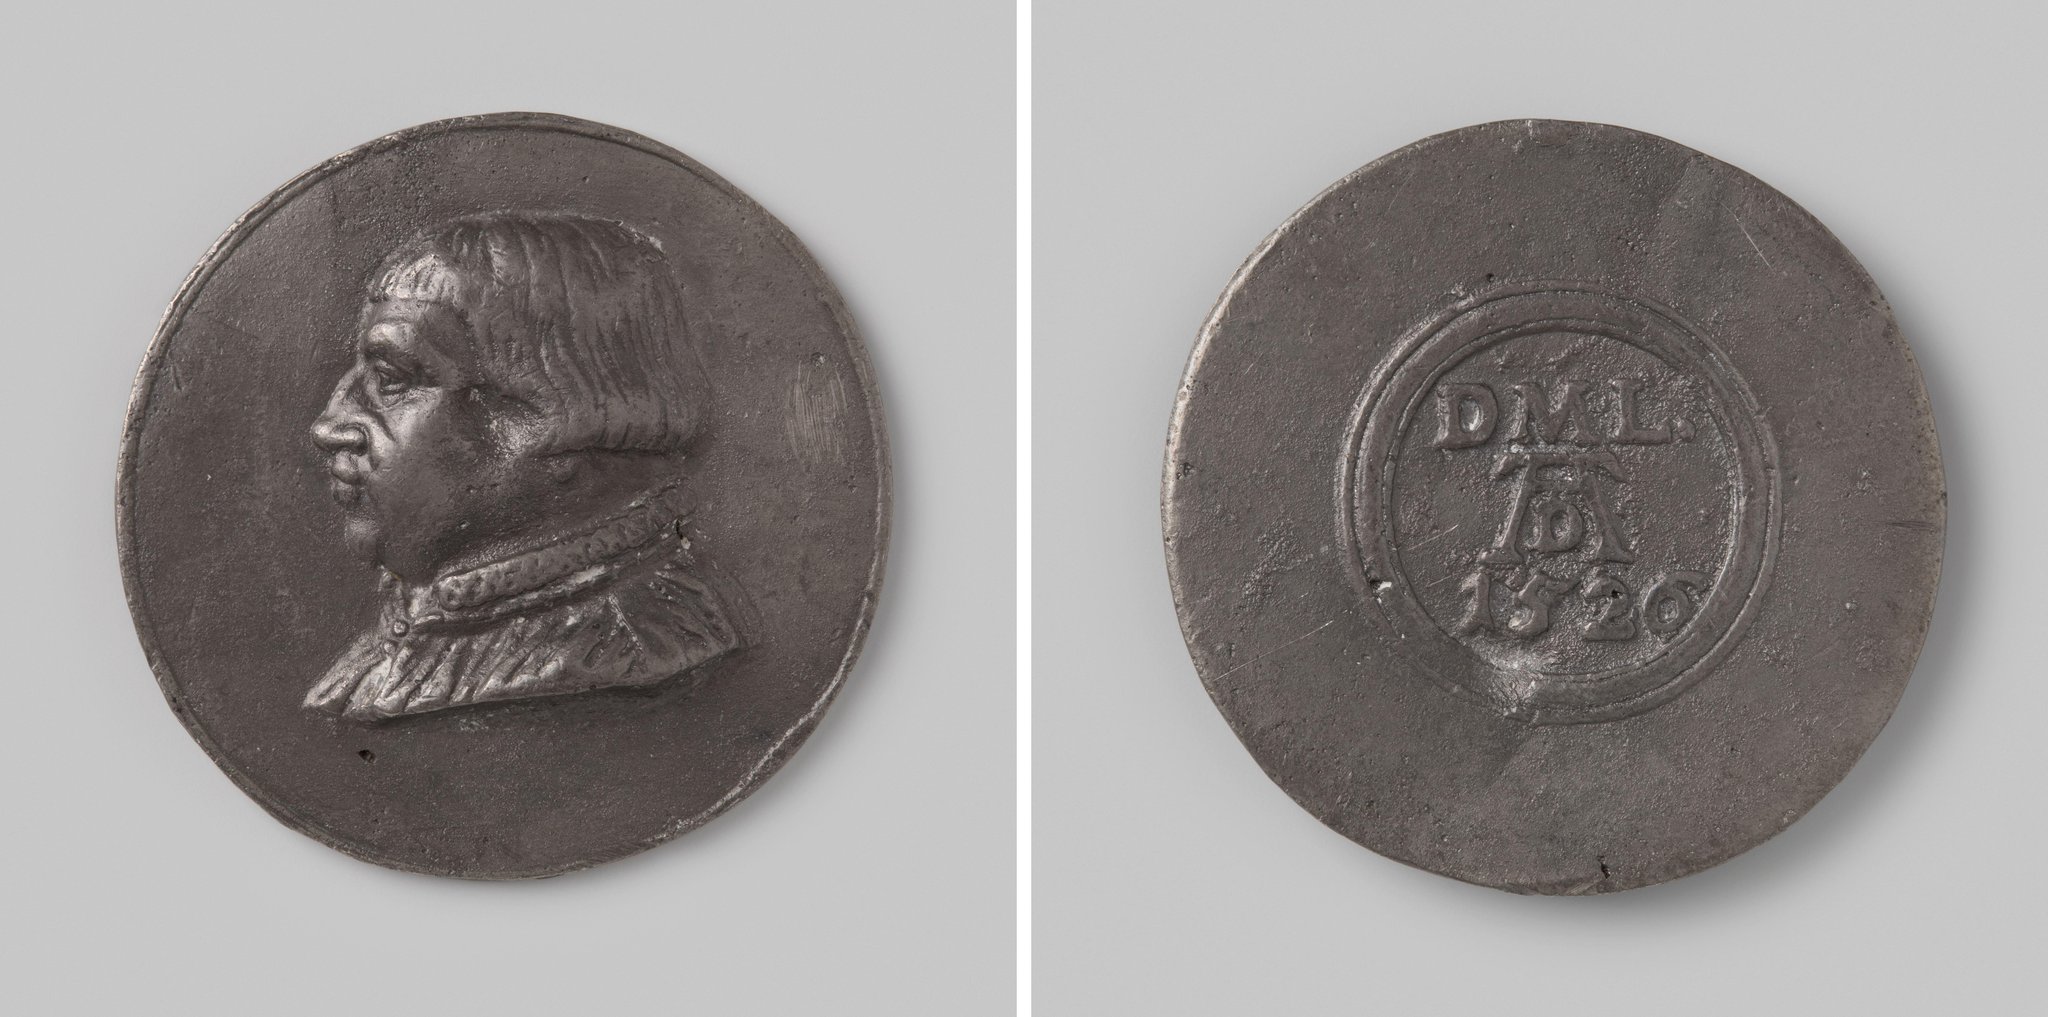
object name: history medal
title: Maarten Luther 1526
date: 1526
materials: tin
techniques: casting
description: Tinnen penning, op de voorzijde het borstbeeld van Luther naar links, op de keerzijde drie regels tekst binnen een drievoudige cirkel.